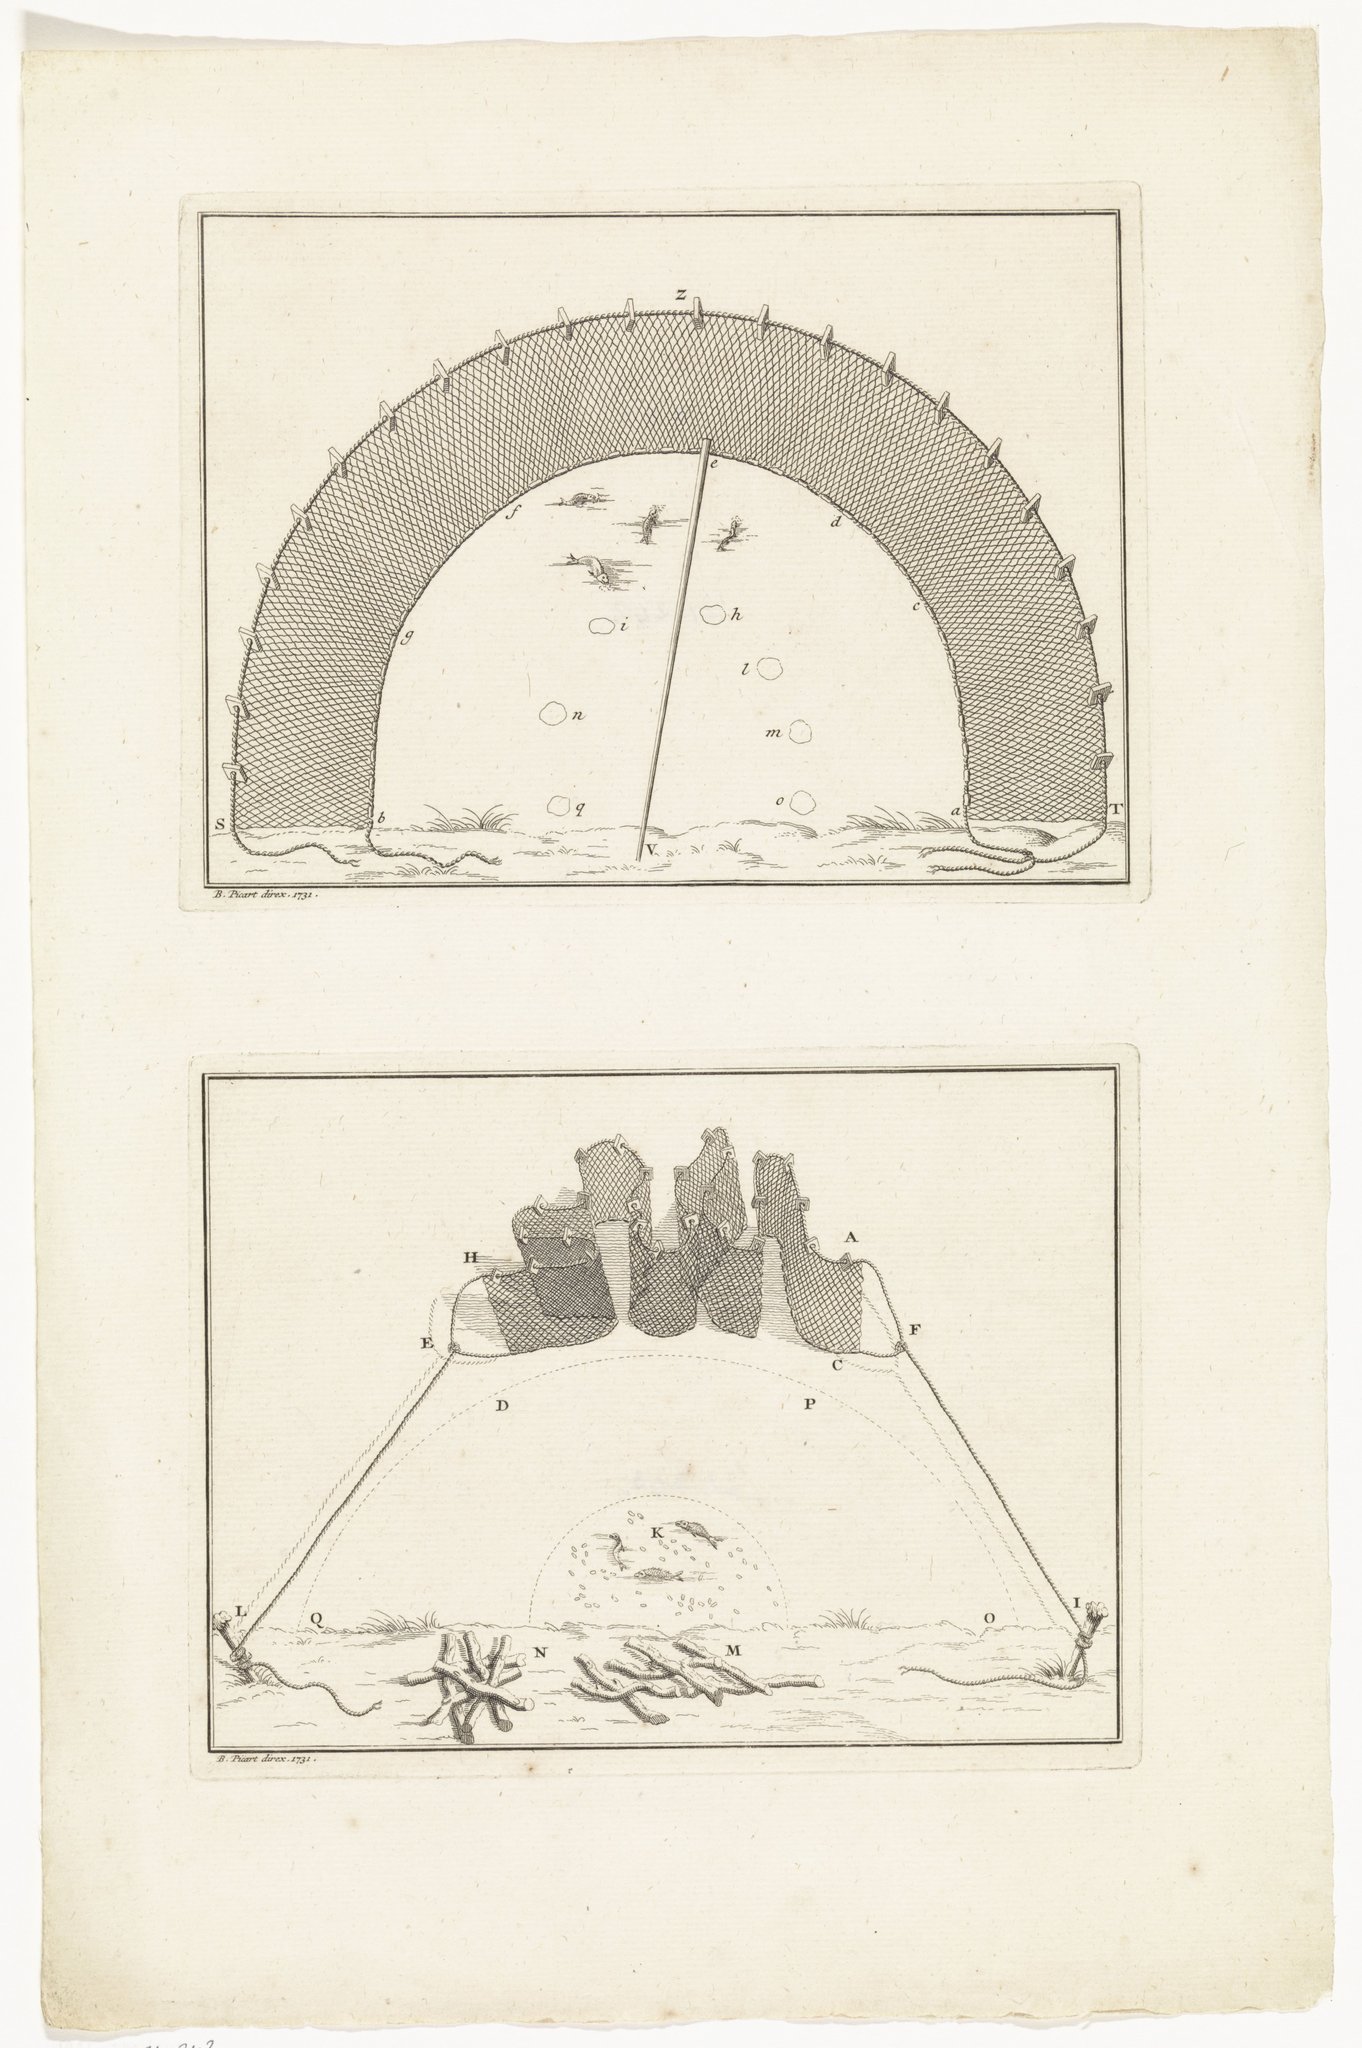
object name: print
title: Twee netten met vissen als lokaas om vogels te vangen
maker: bernard picart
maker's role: draughtsman, print maker, publisher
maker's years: 1673-1733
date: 1731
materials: paper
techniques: etching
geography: amsterdam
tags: bird hunting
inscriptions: collector's mark: Lugt 2233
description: Prenten bedoeld voor: Chomel, Noel. Dictionnaire oeconomique, contenant divers moïens d'augmenter son bien, et de conserver sa santé. Amsterdam: Johannes Covens en Cornelis Mortier, 1732.